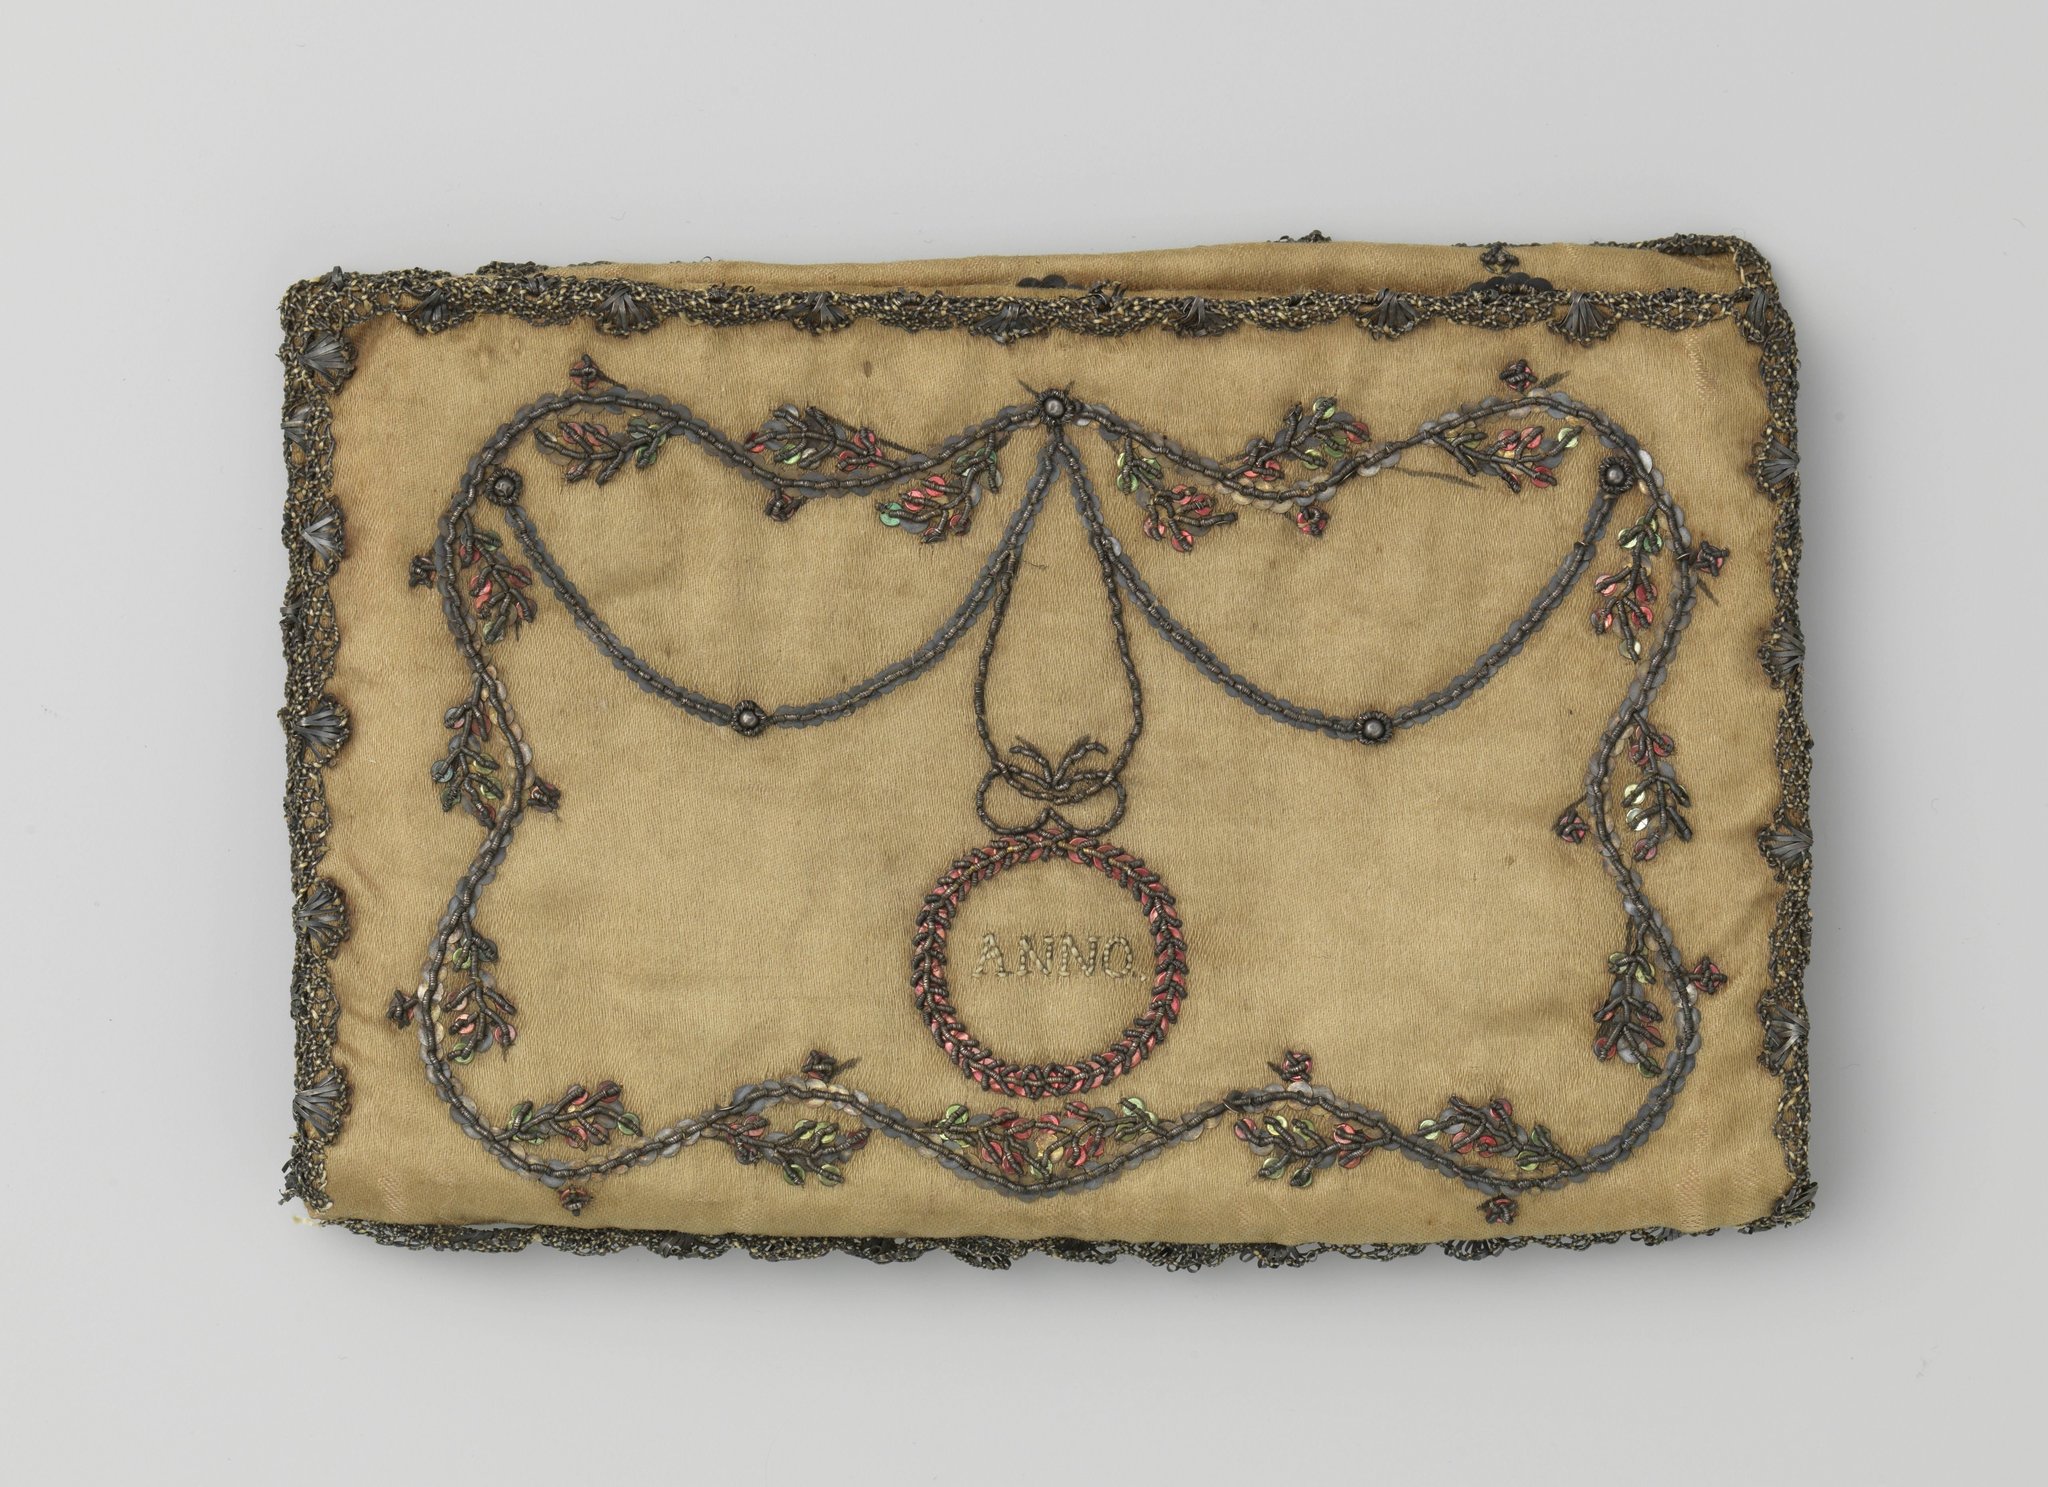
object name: brieventas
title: Brieventas in rechthoekige vorm van lichtbruine zijde afgezet met een boord van goudkant en versierd met metalen lovers en gouddraad, waarop geborduurd 'ANNO' en '1781'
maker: Anonymous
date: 1781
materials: gold thread, sequin, silk, thread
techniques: embroidered, weave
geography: france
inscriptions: date: ‘'ANNO' en '1781'’, inscription: ‘'JE SUIS DISCRET' en 'POUR L'AMITIE'’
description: Brieventas in rechthoekige vorm van lichtbruine zijde, afgezet met een boord van goudkant. De tas is dubbelgevouwen. De buitenkant is identiek versierd als de binnenkant: een slingerende rand van aaneengesloten zilveren lovers, vastgezet met zilverdraad, waarlangs gestileerde bloemen in gekleurde metalen lovers. In deze omlijsting een guirlande en aan een strik een medaillon waarbinnen aan de buitenkant van de tas 'ANNO' en '1781' is geborduurd. Aan de binnenkant van de tas 'JE SUIS DISCRET' en 'POUR L'AMITIE' op dezelfde wijze aangebracht. De twee vakken binnenin zijn gevoerd met ponjé-zijde.